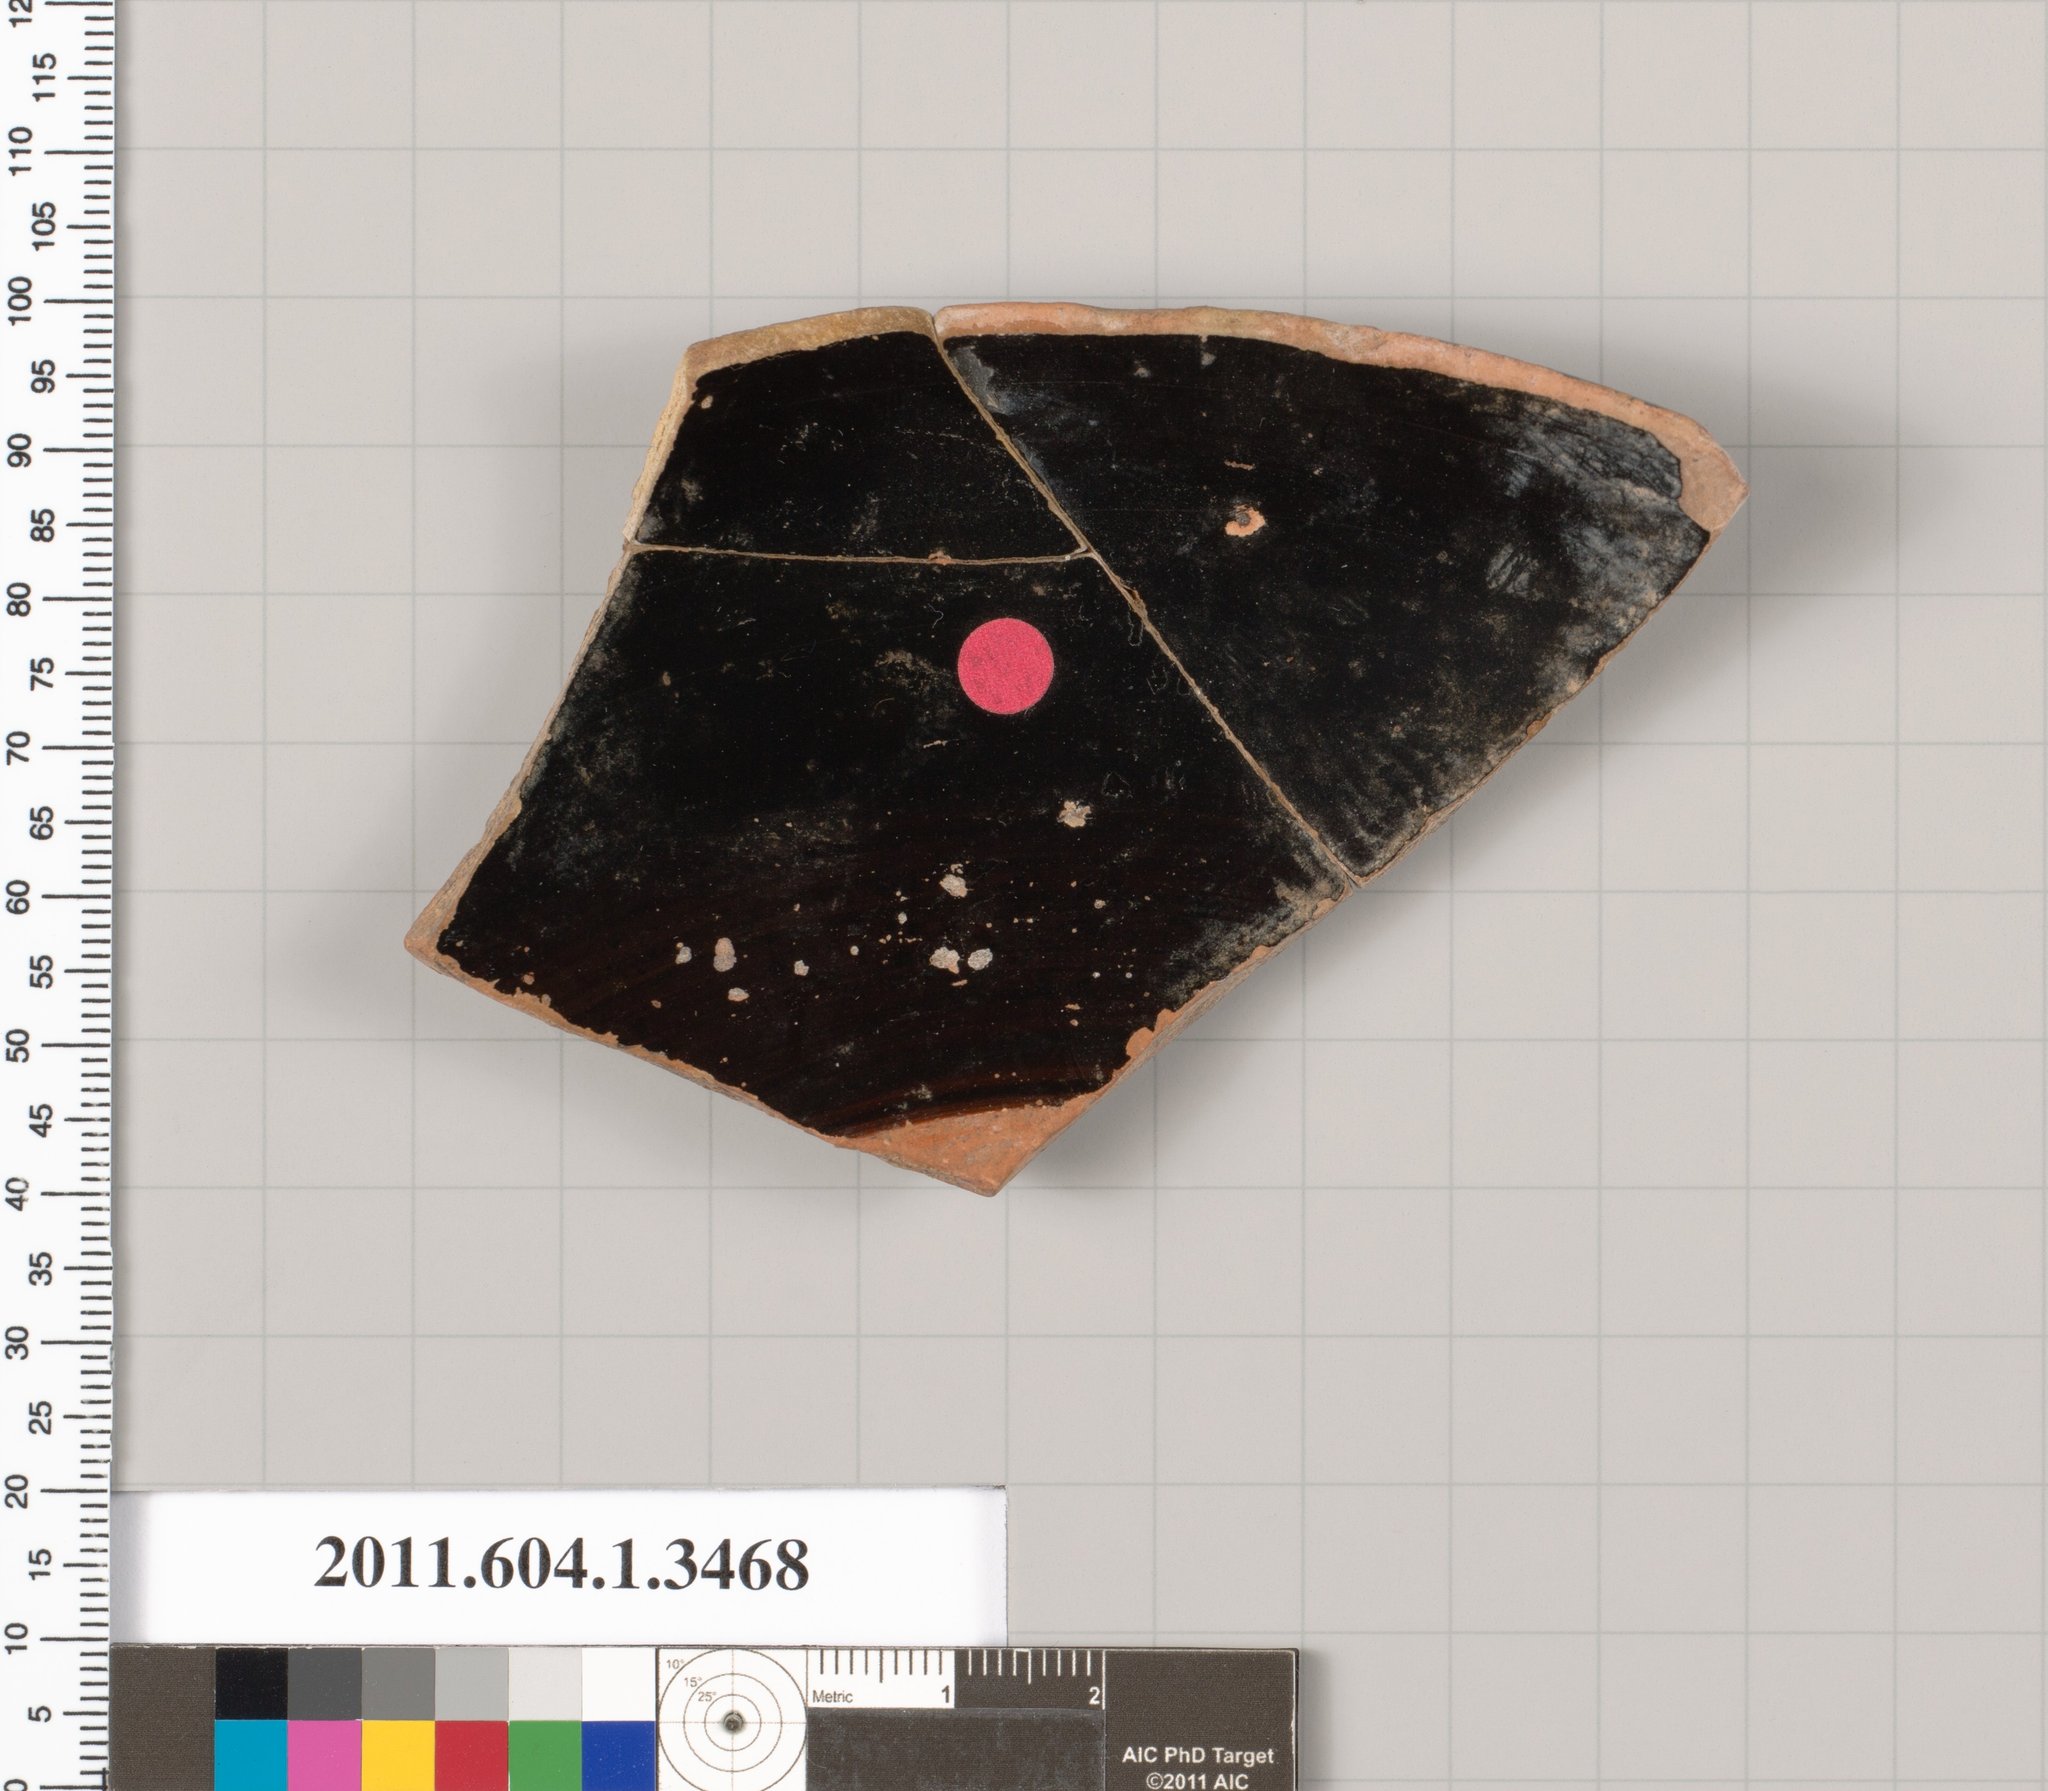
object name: kylix fragment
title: Terracotta fragment of a kylix (drinking cup)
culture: greek, attic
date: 600-401 BCE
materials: terracotta